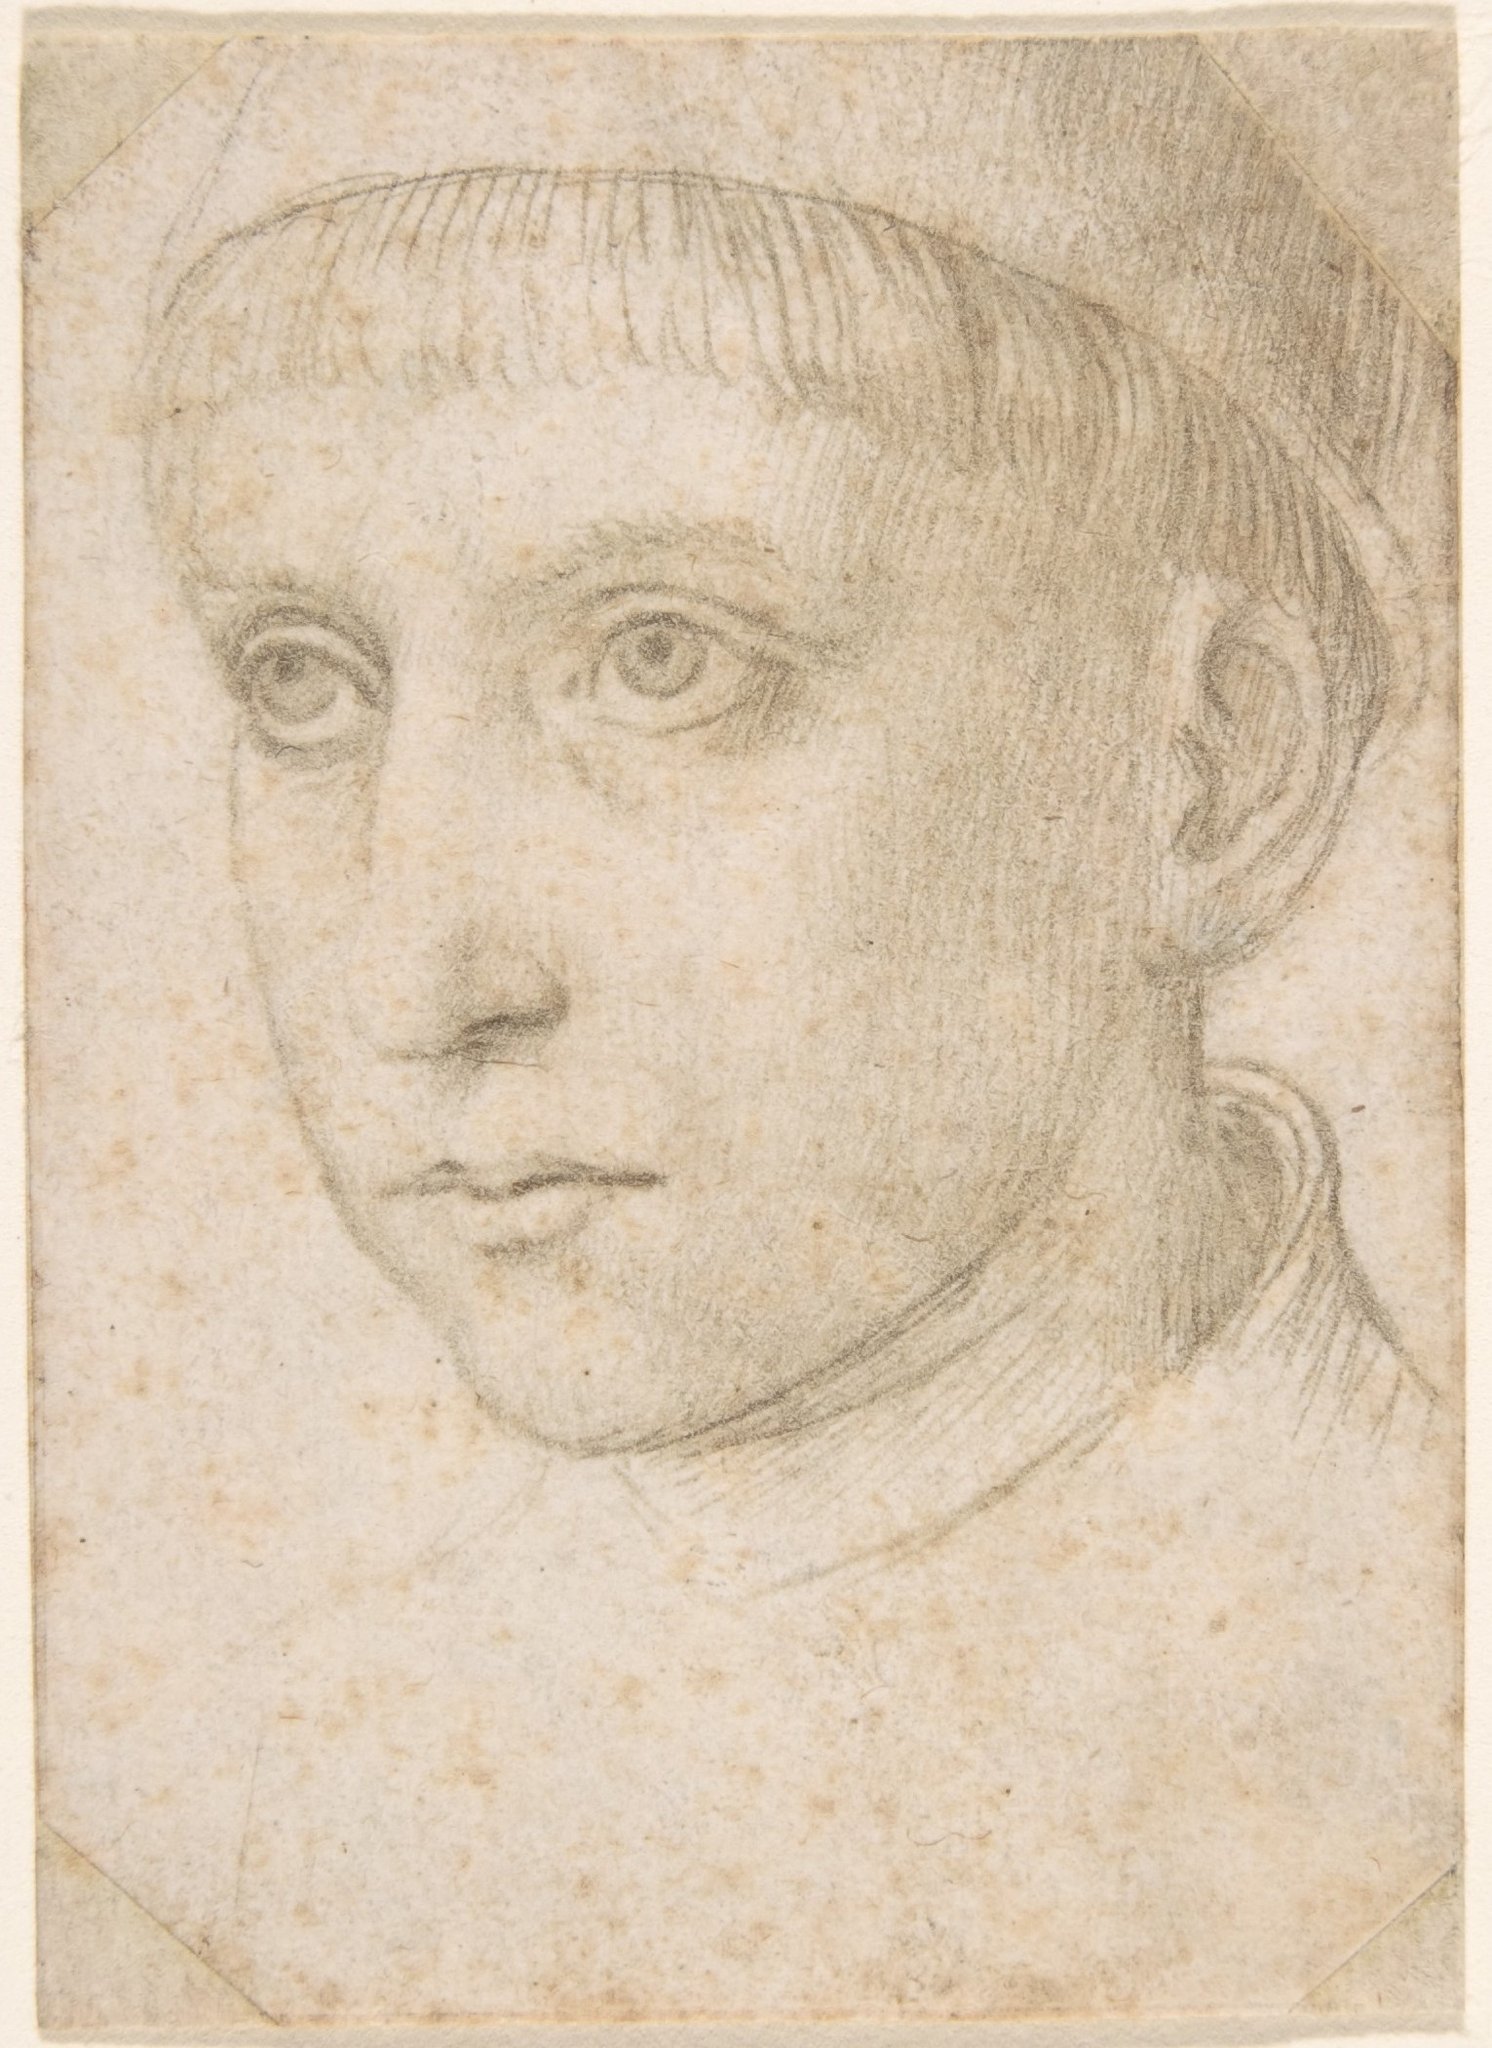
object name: drawing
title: Head of a Boy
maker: master of the legend of saint ursula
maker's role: artist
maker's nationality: netherlandish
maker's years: 1465-1490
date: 1401-1500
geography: netherlands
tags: heads,boys,portraits